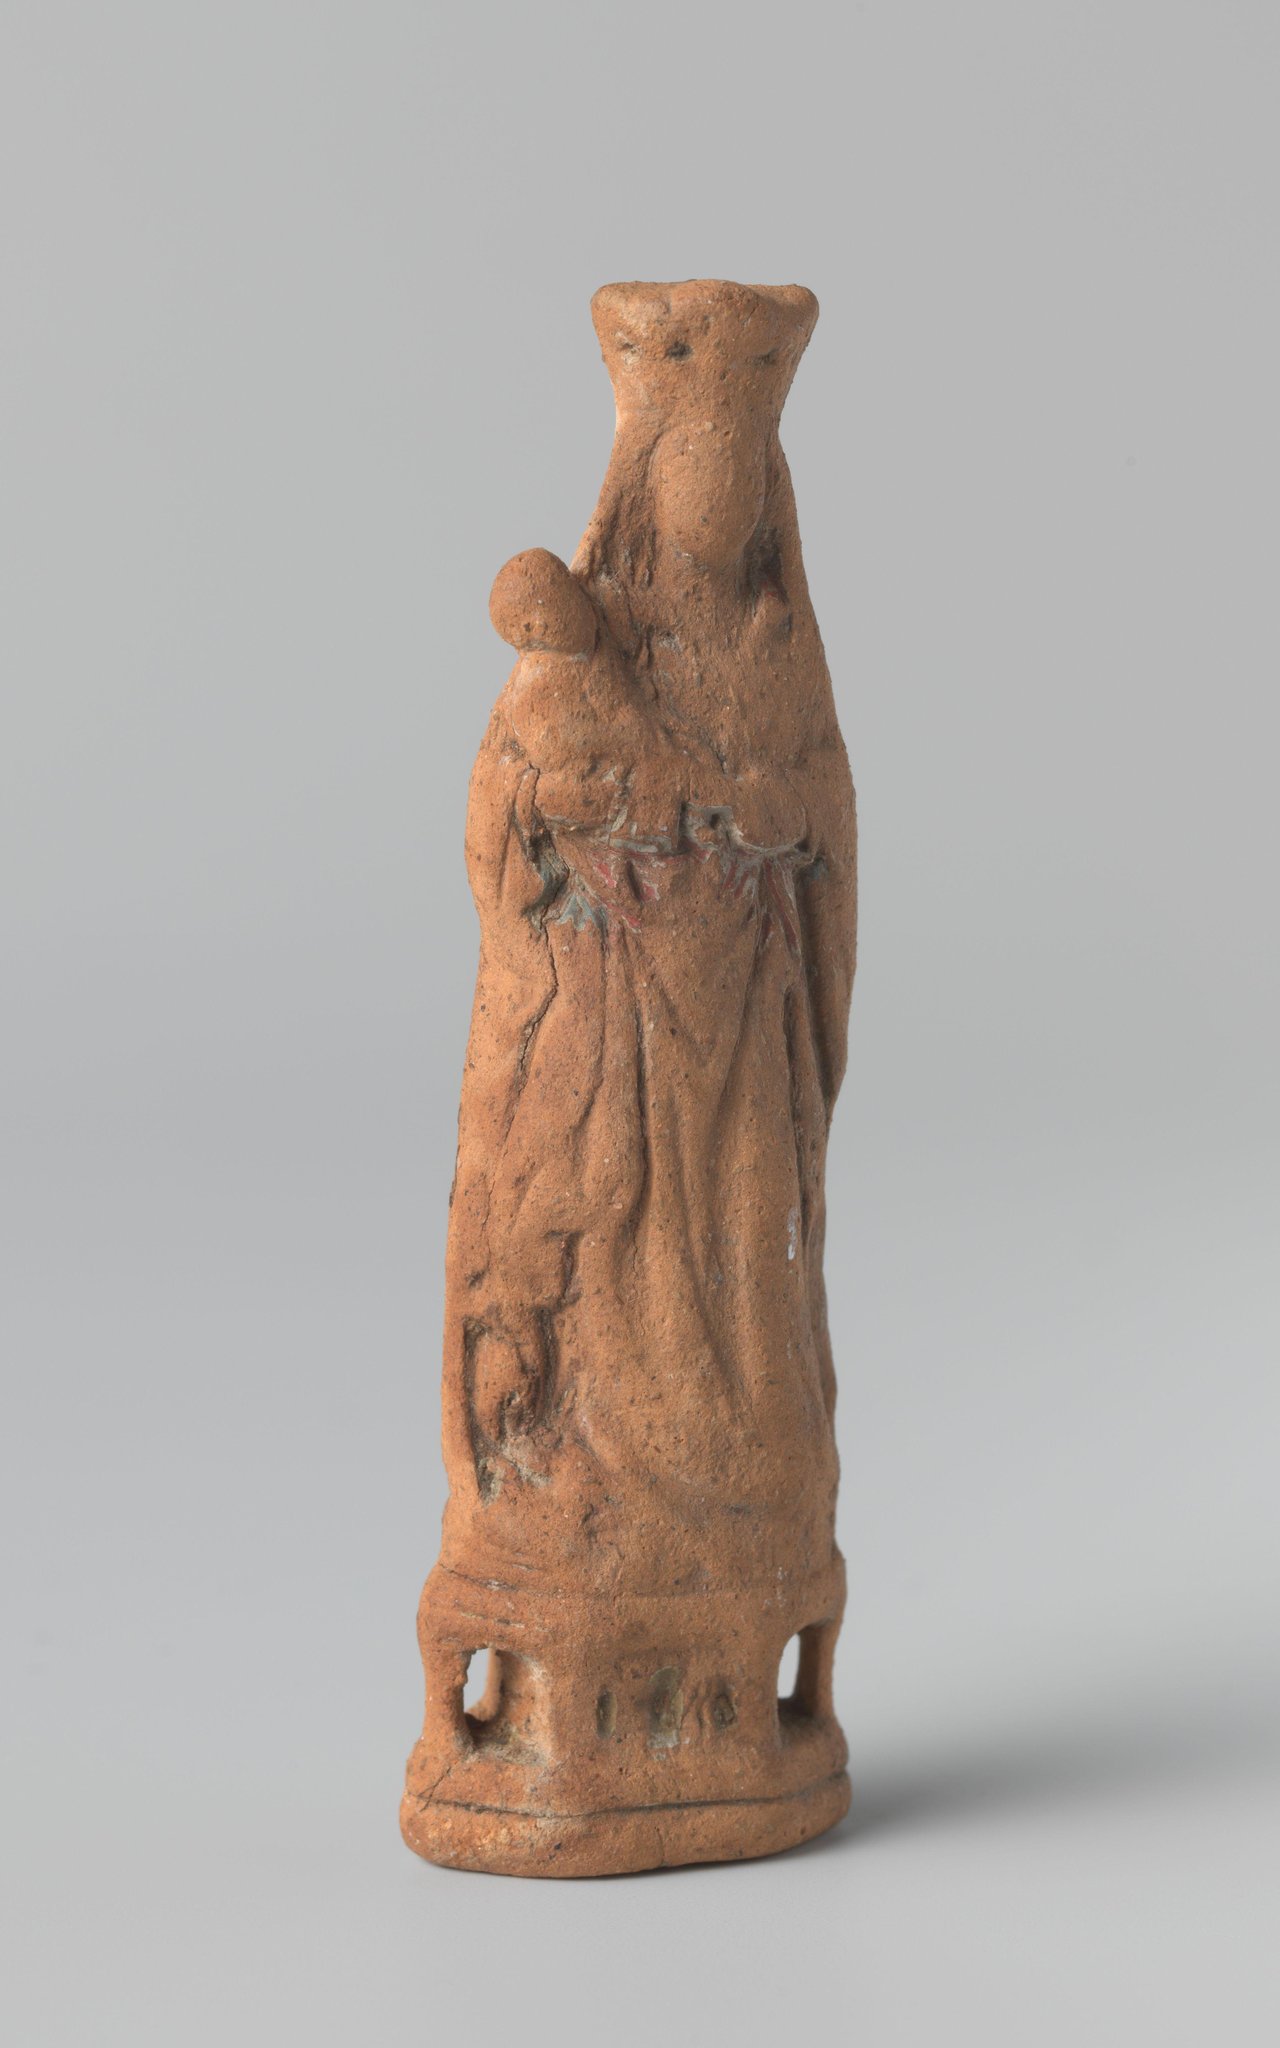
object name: sculpture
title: Virgin and Child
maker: Anonymous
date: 1425-1450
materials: terracotta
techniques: firing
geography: utrecht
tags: joseph désiré de lupus